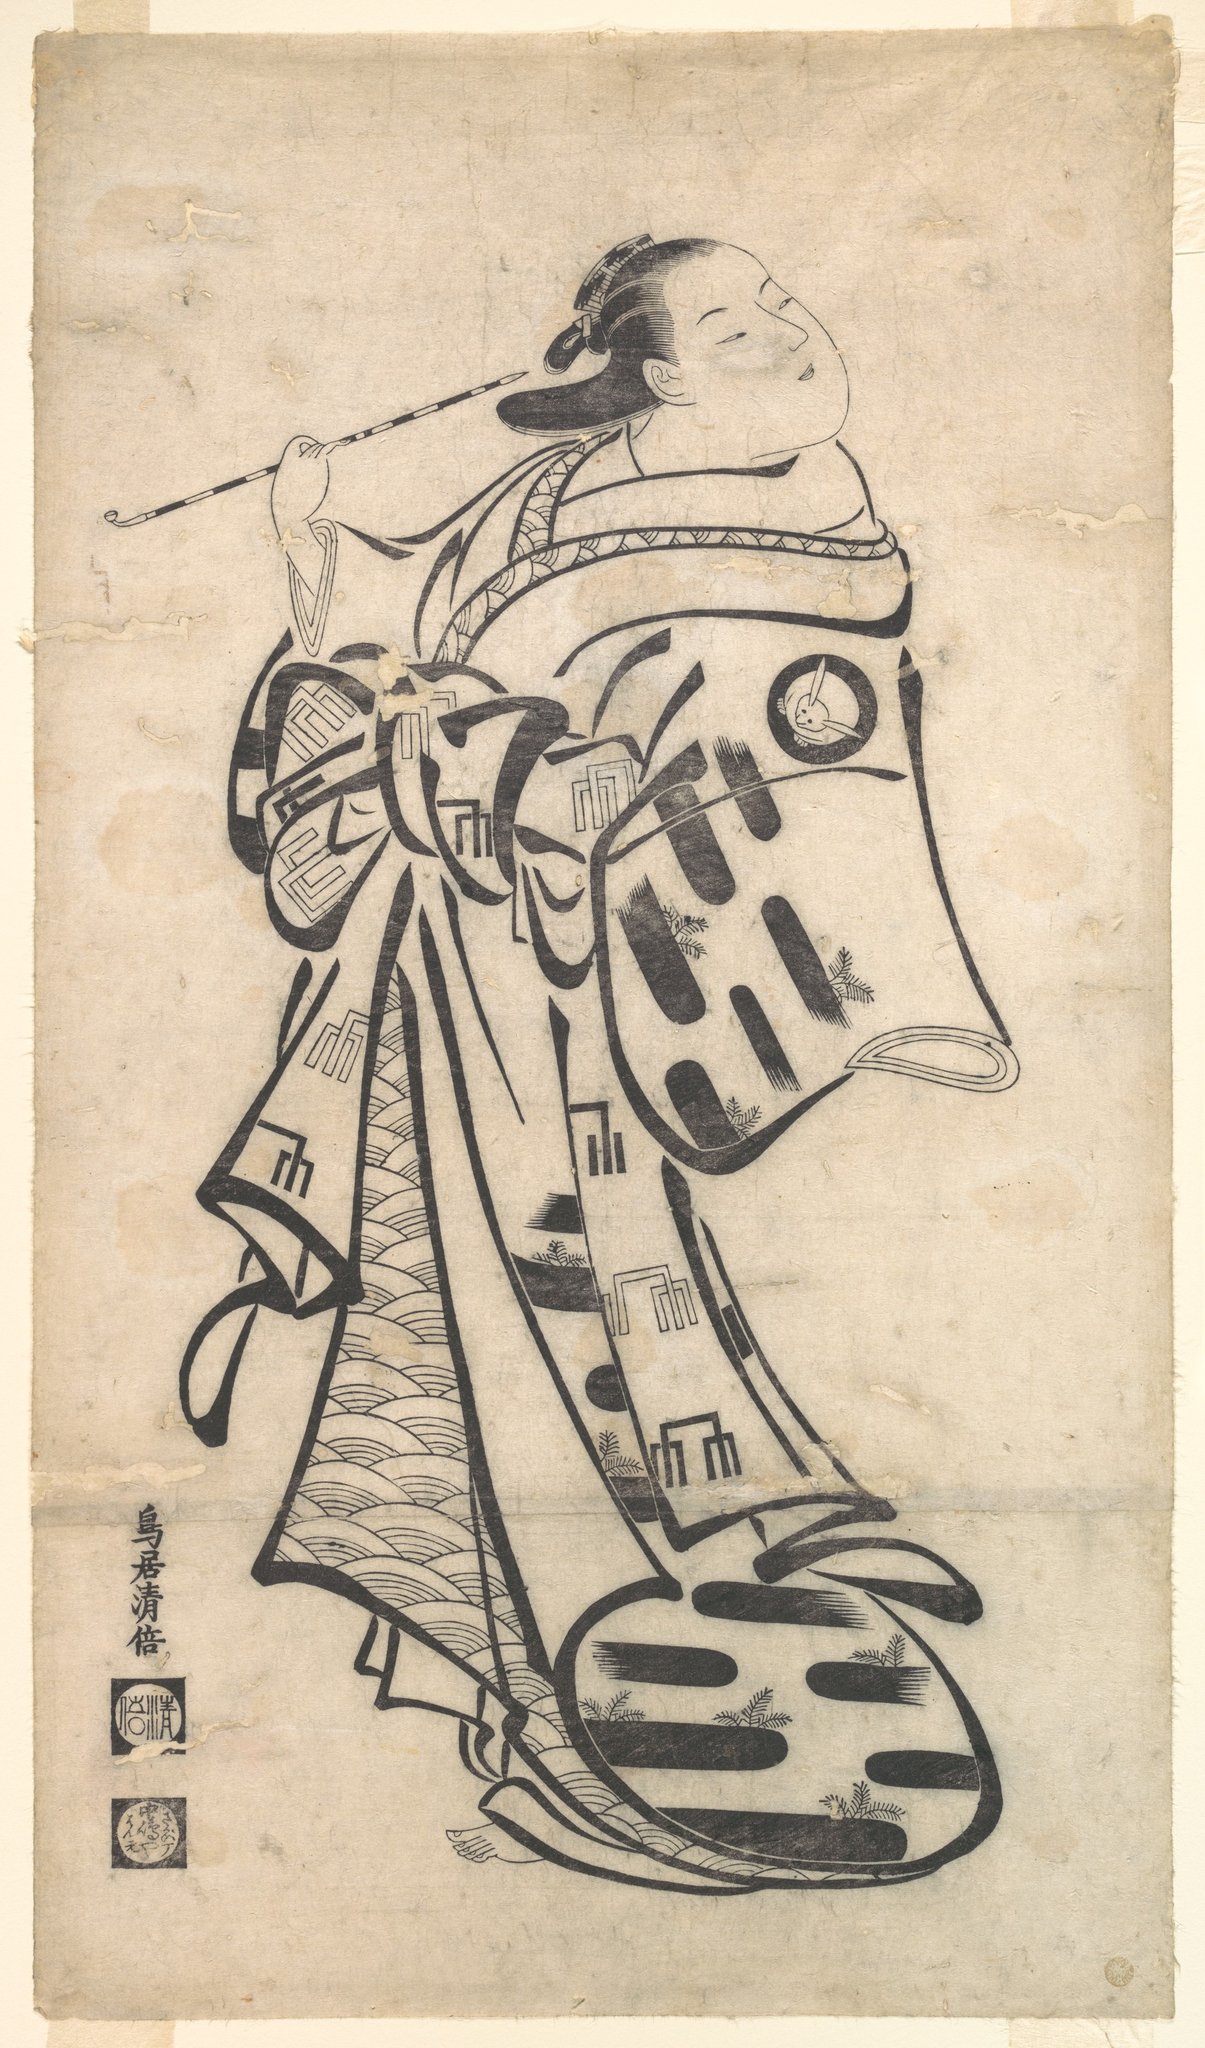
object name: woodblock print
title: An Oiran Standing, a Pipe in Her right Hand, and Turning to Look Behind over Her Shoulder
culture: japanese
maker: torii kiyomasu i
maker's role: artist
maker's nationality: japanese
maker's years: 1696-1716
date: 1705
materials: ink, paper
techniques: woodblock print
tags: women